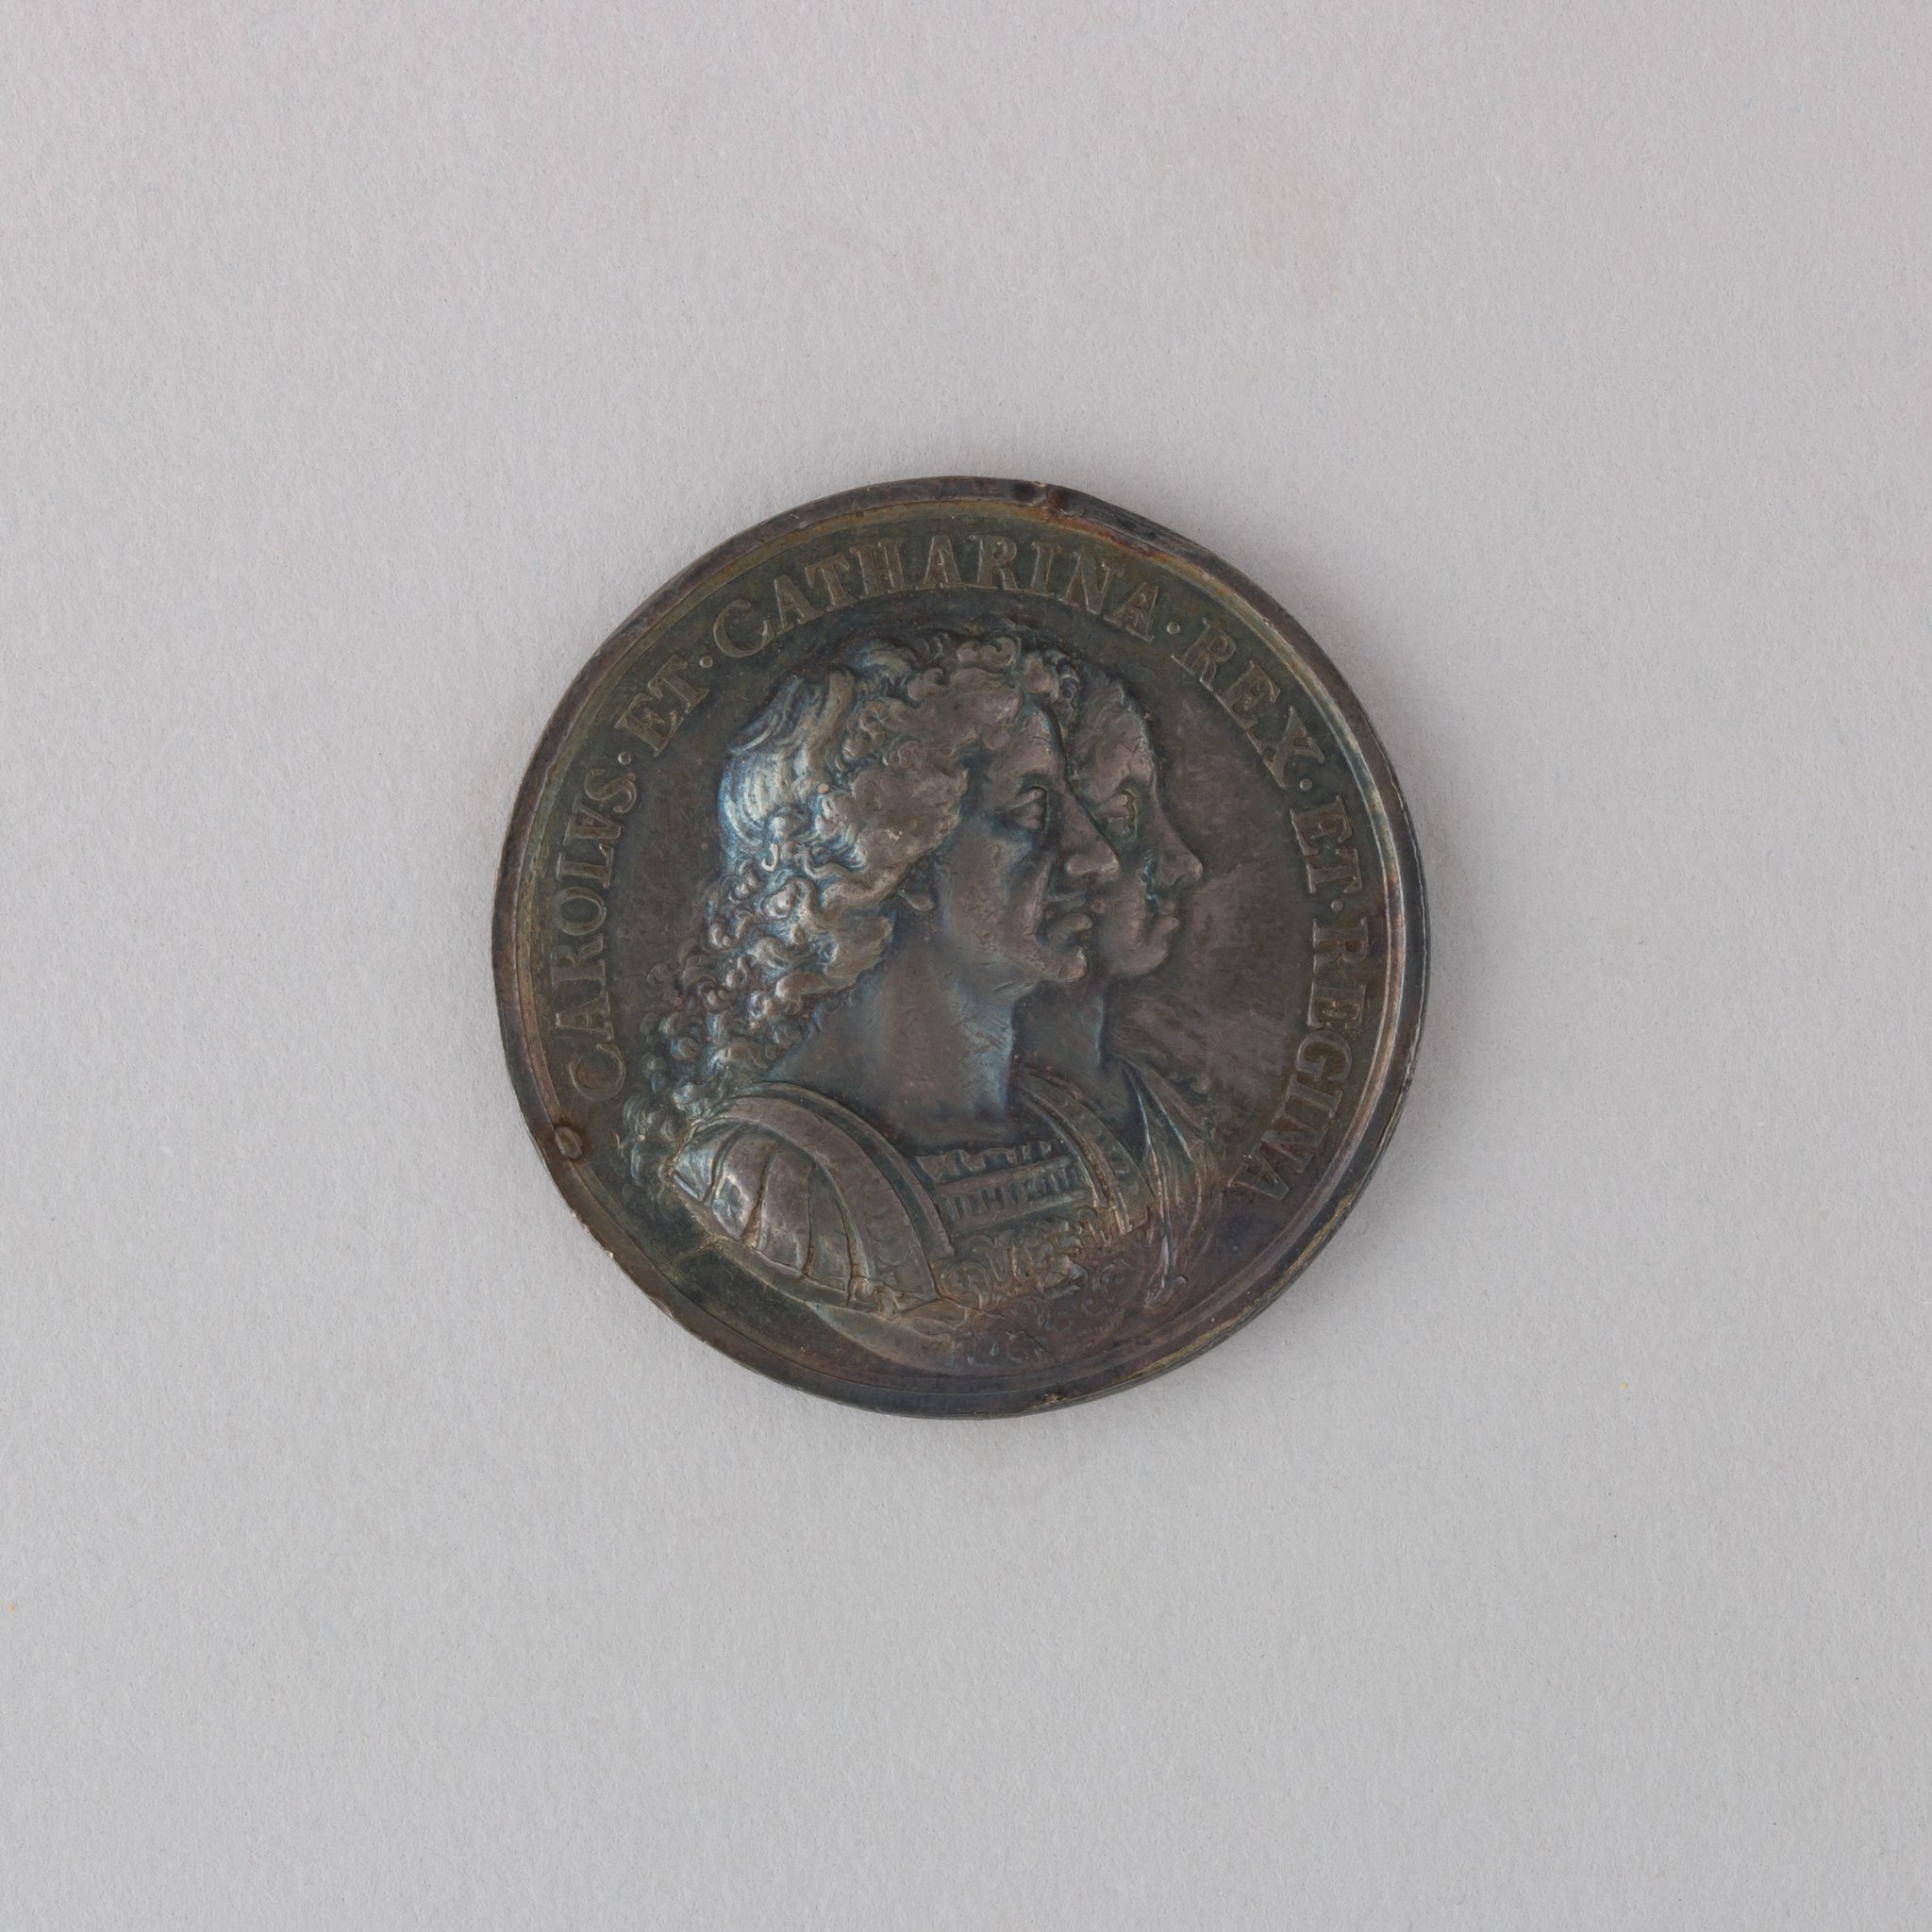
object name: medal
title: Medal of British Colonization Showing Charles II and Catherine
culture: british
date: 1670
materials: silver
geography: england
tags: men,profiles,women